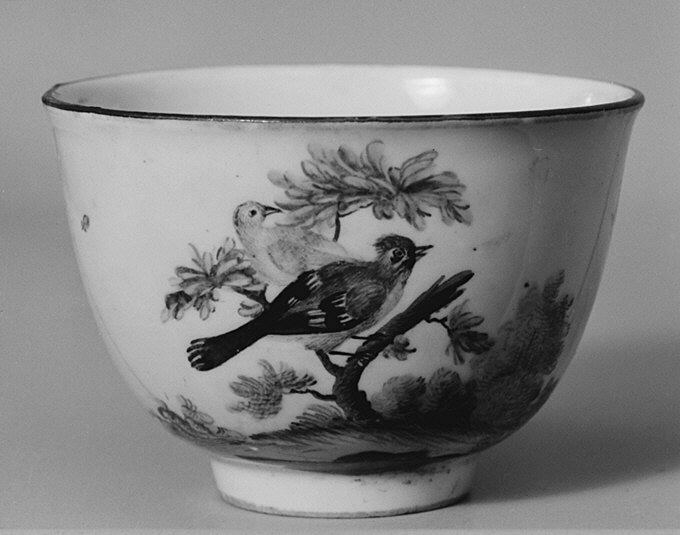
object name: cup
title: Cup (part of a service)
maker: frankenthal porcelain manufactory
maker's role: manufactory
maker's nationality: german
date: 1770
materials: hard paste porcelain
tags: birds,flowers